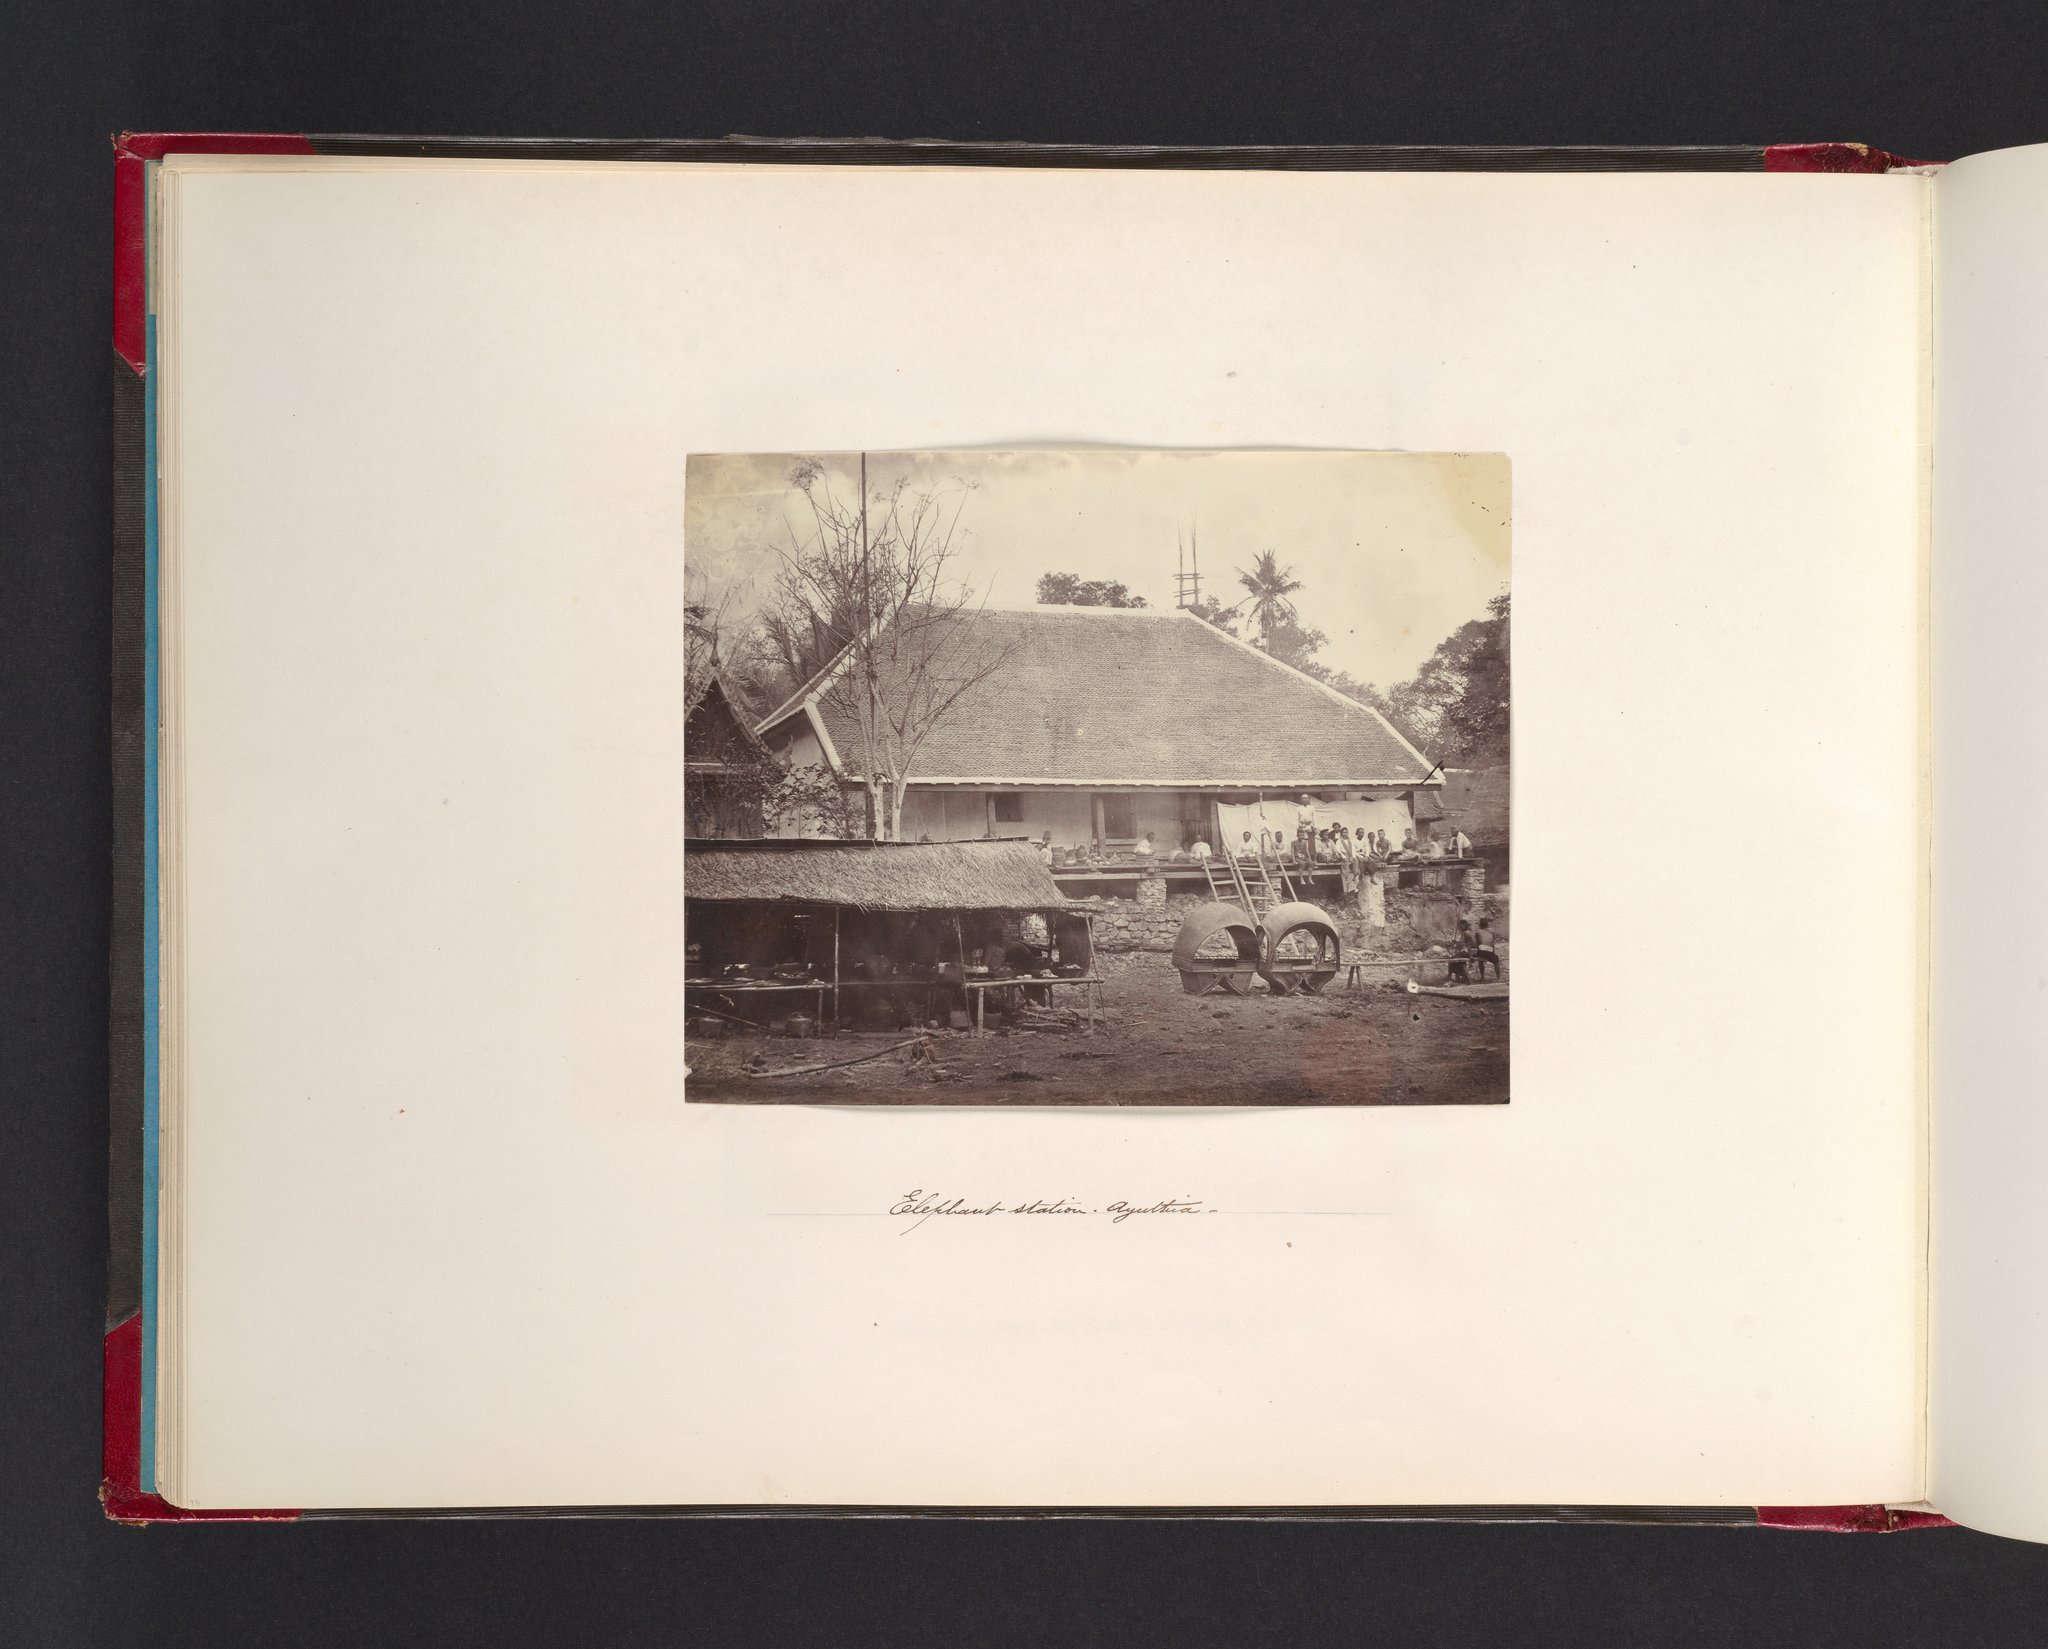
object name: photograph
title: Elephant Station, Ayuthia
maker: john thomson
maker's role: artist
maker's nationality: british, scottish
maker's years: 1837-1921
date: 1865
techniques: albumen silver print, glass negative